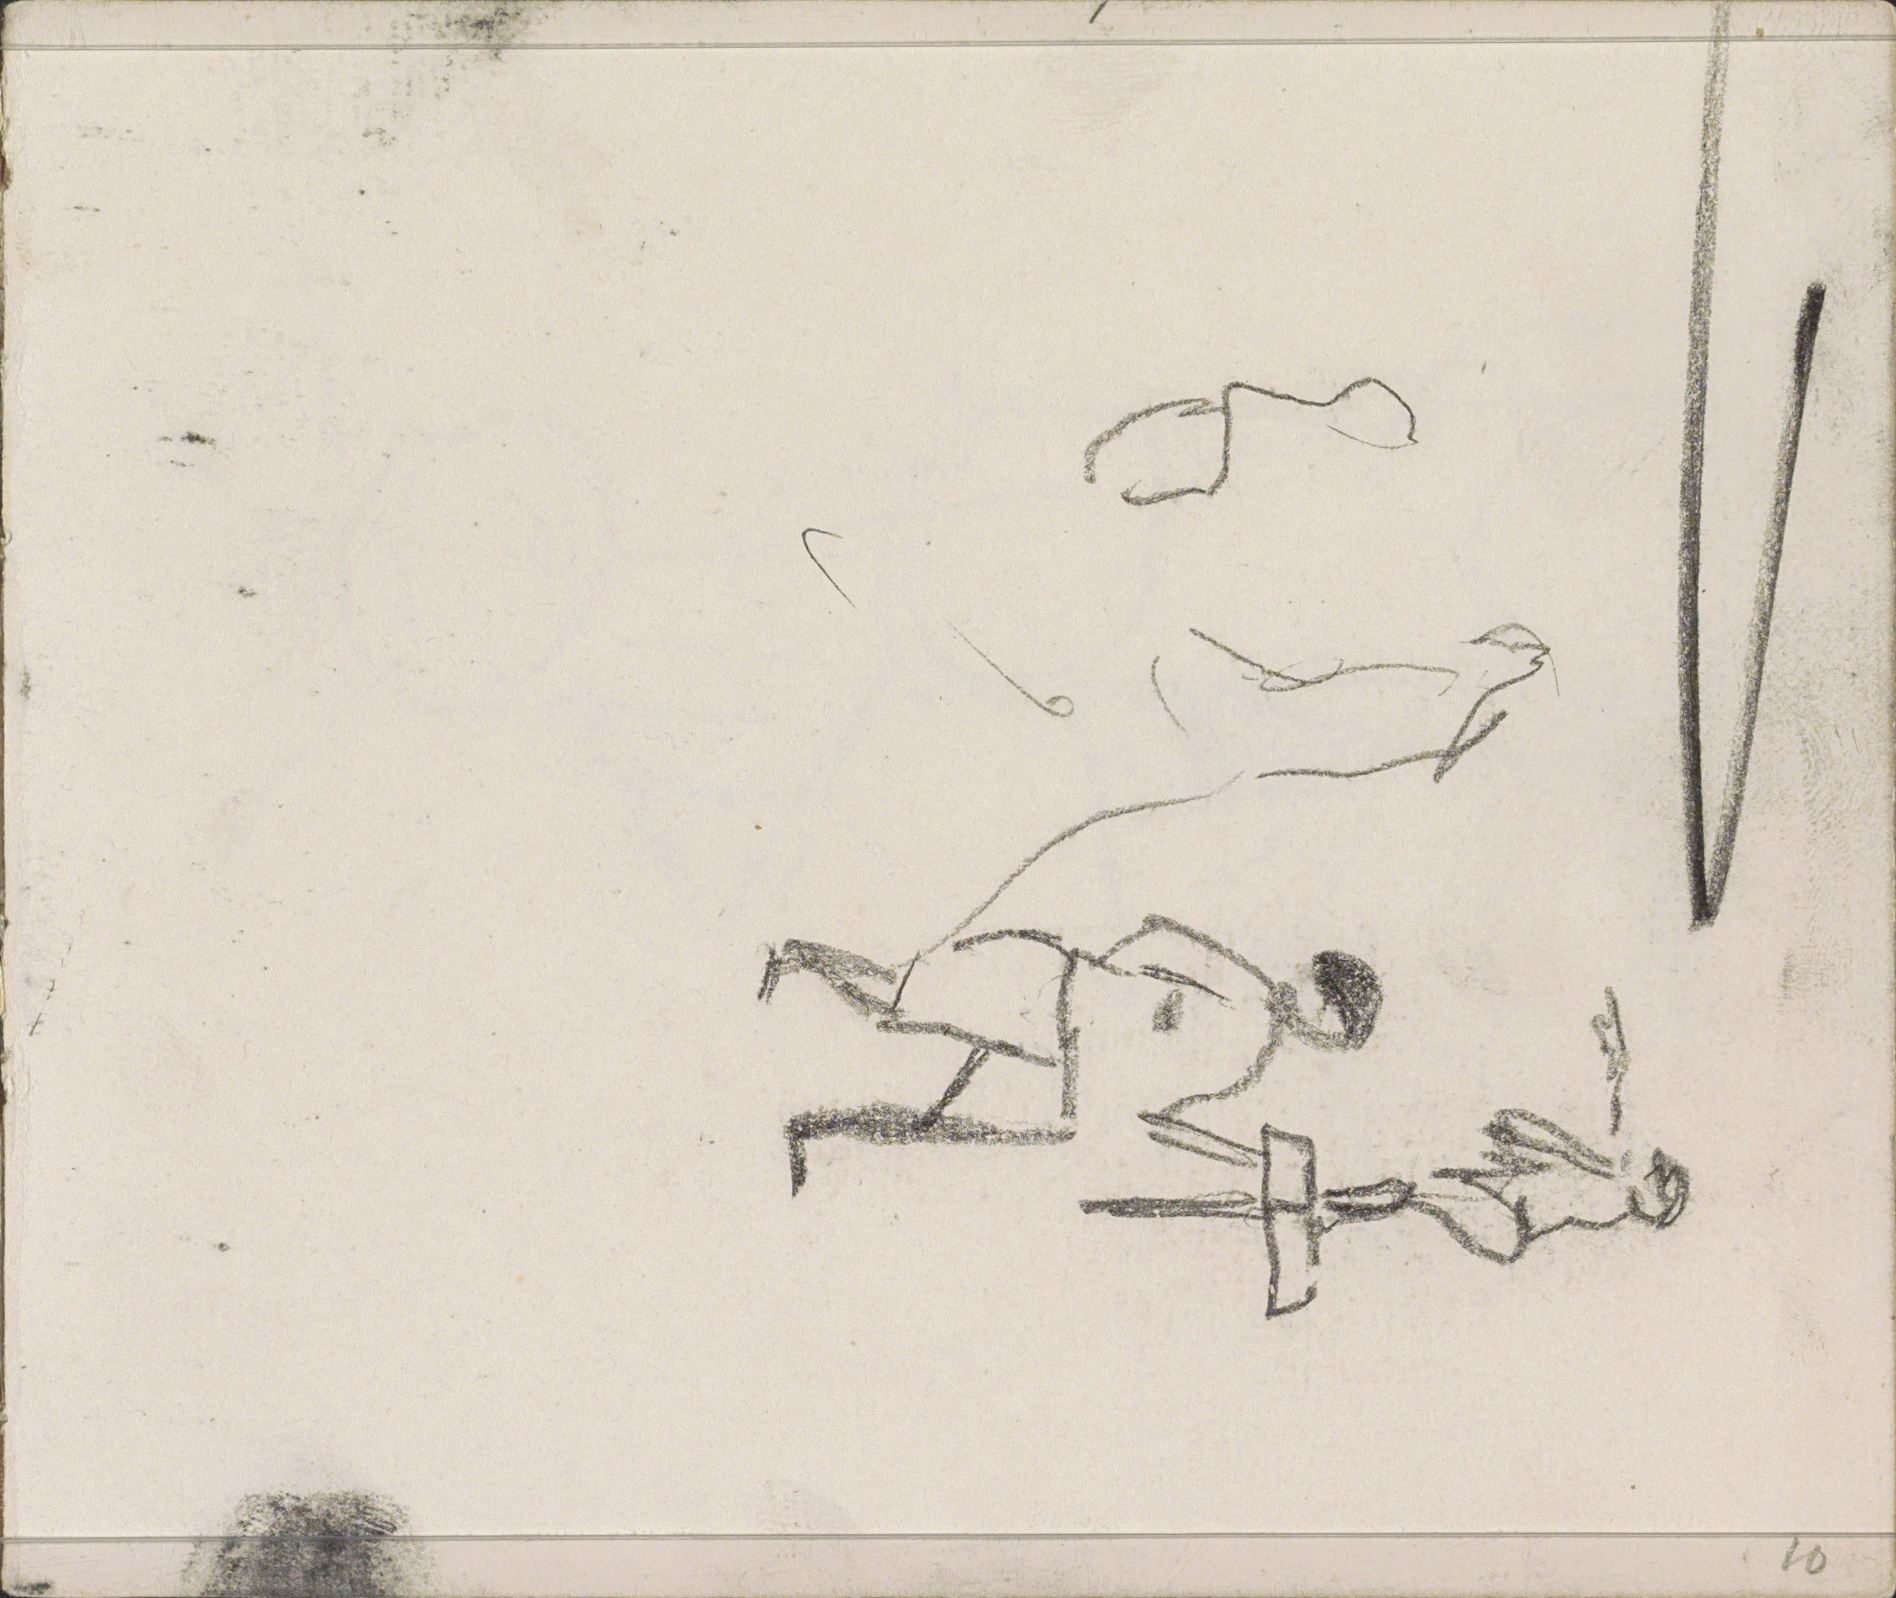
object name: sketchbook leaf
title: Figuurstudies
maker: isaac israels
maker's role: draughtsman, painter, print maker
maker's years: 1865-1934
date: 1886-1934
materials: chalk, paper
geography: amsterdam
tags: standing figure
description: Een figuur staat op een verhoging en wijst. Blad 10 recto uit schetsboek LIV met 18 bladen.